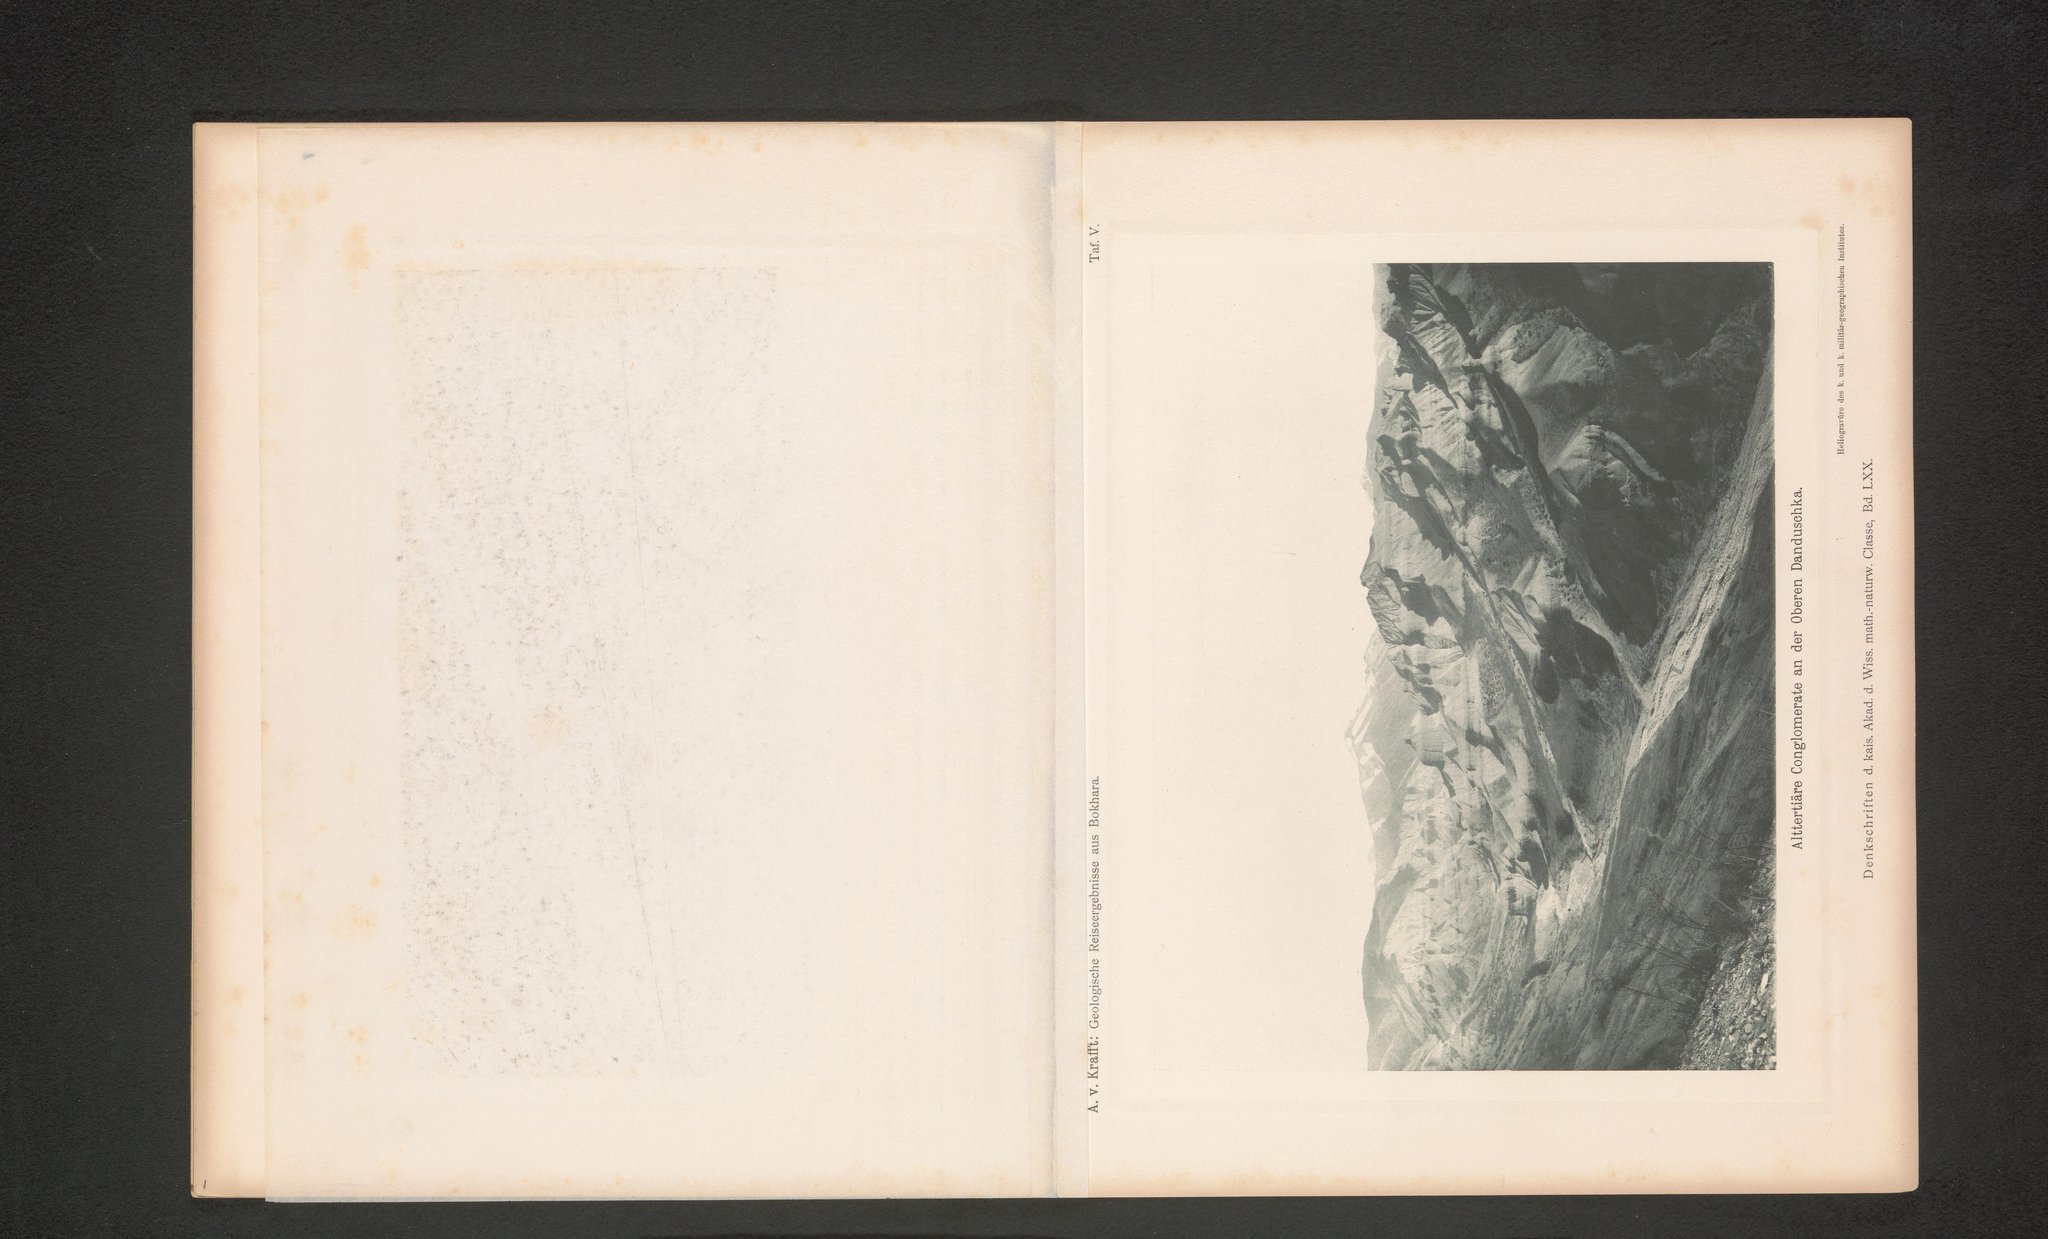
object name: photomechanical print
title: Alttertiäre Conglomerate an der Oberen Danduschka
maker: a. von krafft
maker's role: auteur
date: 1896-1901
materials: paper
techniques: photoaquatint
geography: bukhara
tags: mountains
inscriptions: number: ‘Taf. V.’, inscription: ‘Denkschriften d. kais. Akad. d. Wiss. math.-naturw. Classe, Bd. LXX.’